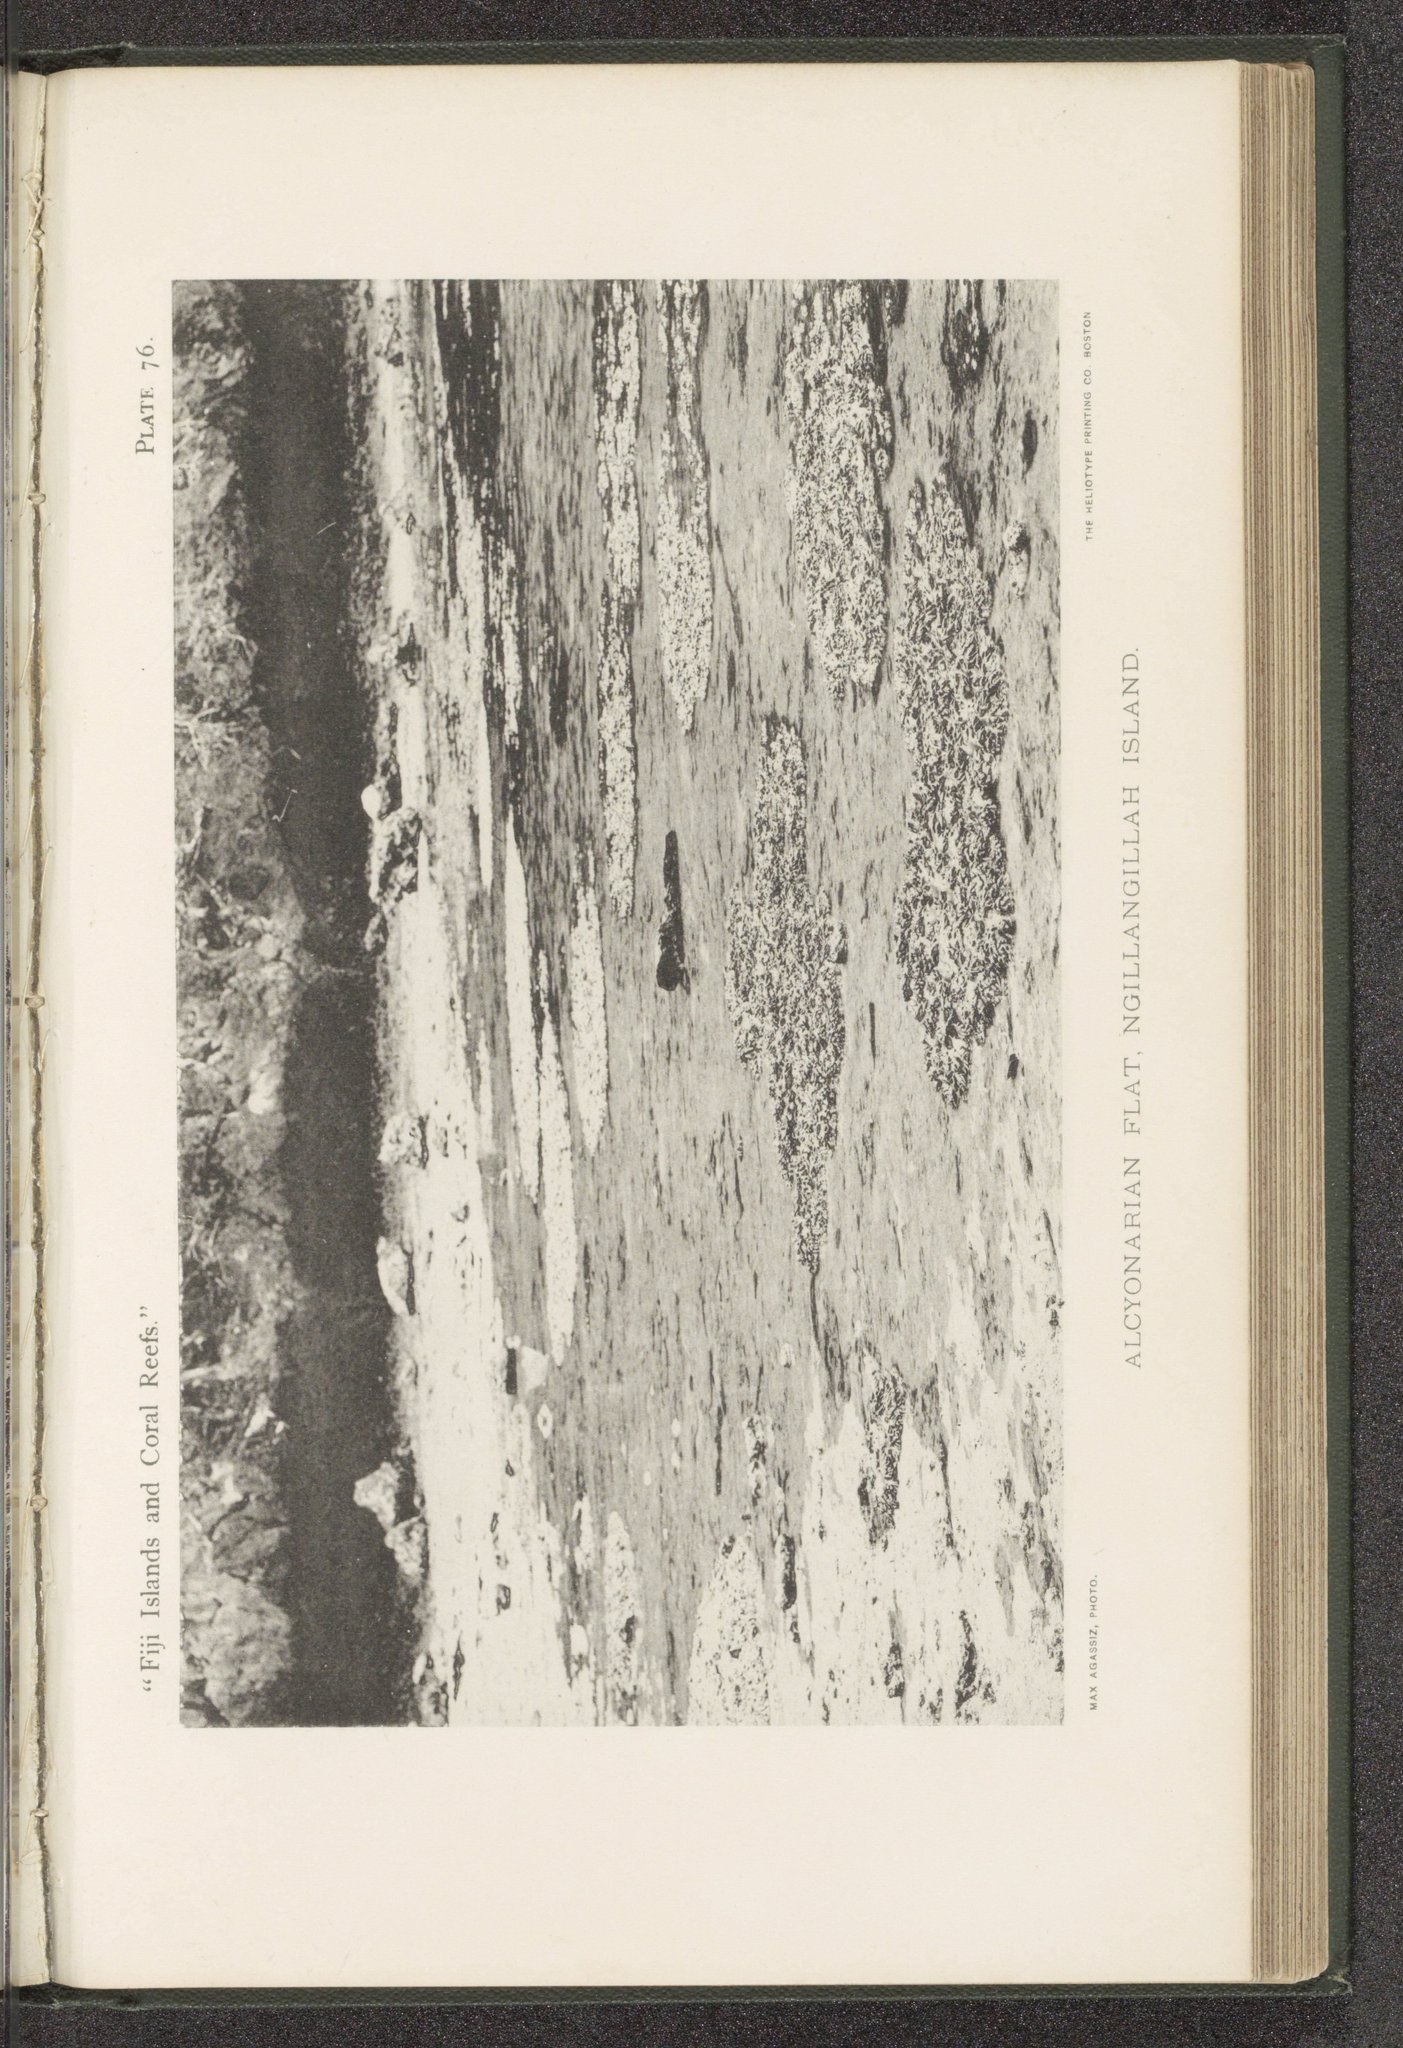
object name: page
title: Gezicht op een vlakte met octocorallia voor een eiland van Fiji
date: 1885-1899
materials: paper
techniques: photograph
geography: boston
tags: coral reef, coast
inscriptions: name: ‘The Heliotype Printing Co. Boston’, number: ‘Plate 76.’, name: ‘Max Agassiz, Photo.’